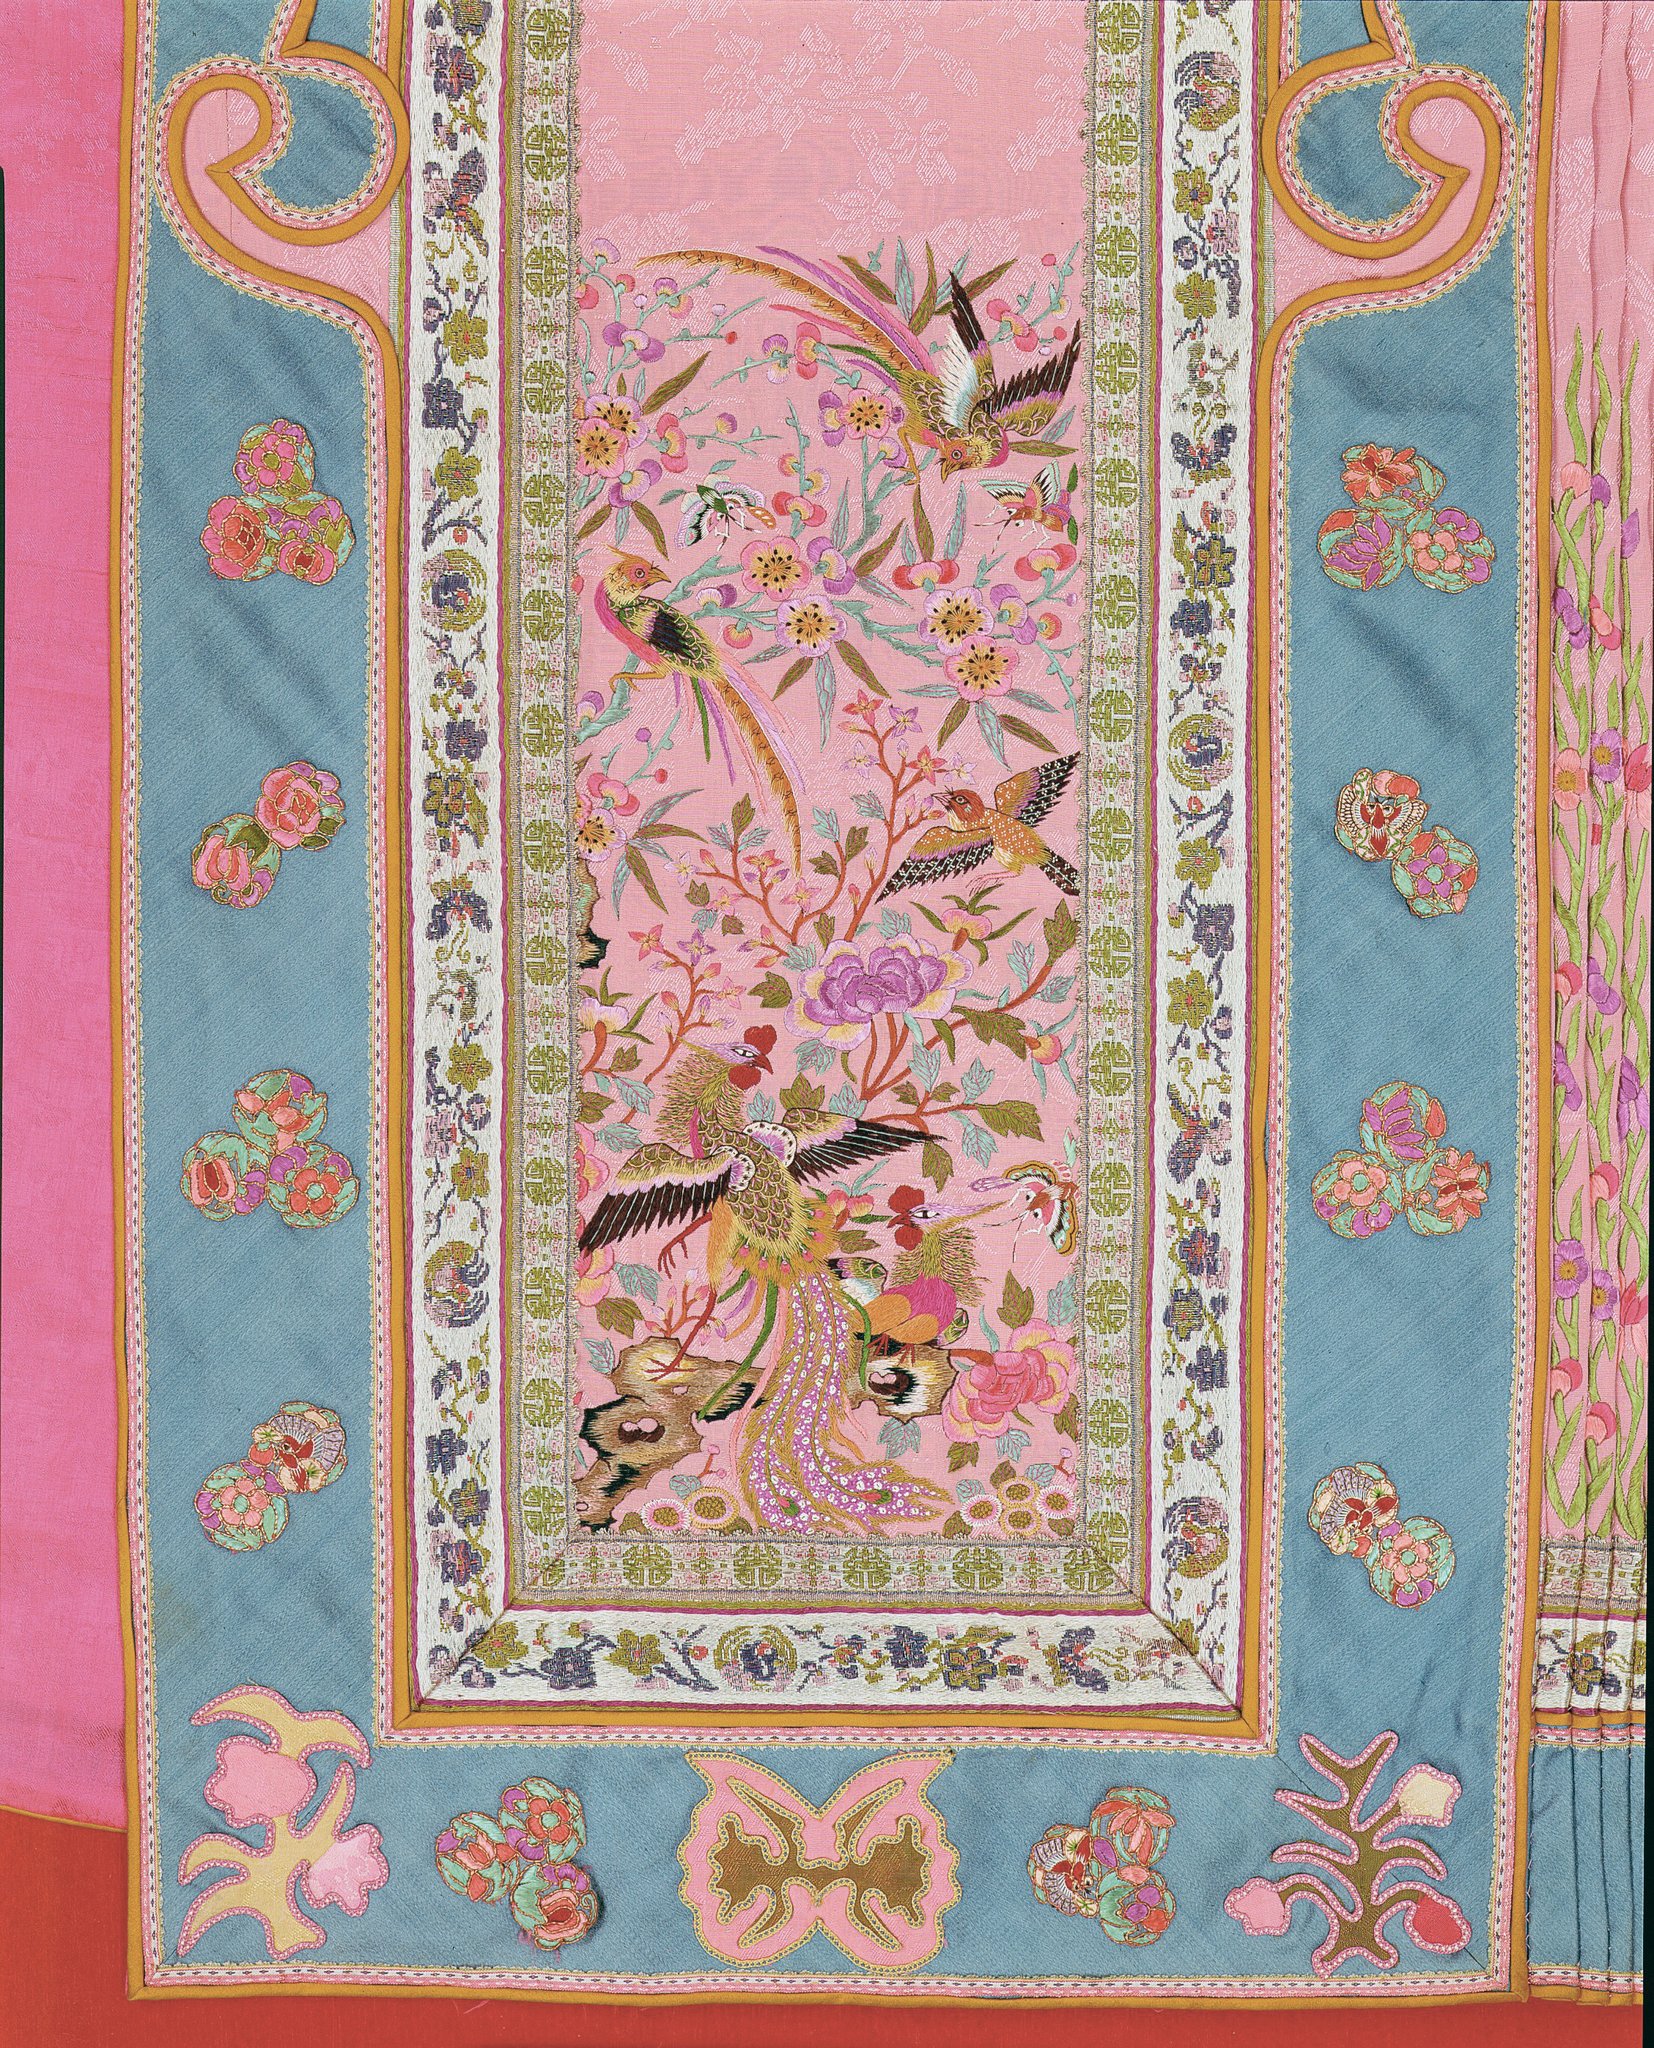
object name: woman's informal skirt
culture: chinese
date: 1801-1900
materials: metal thread, silk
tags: birds,flowers